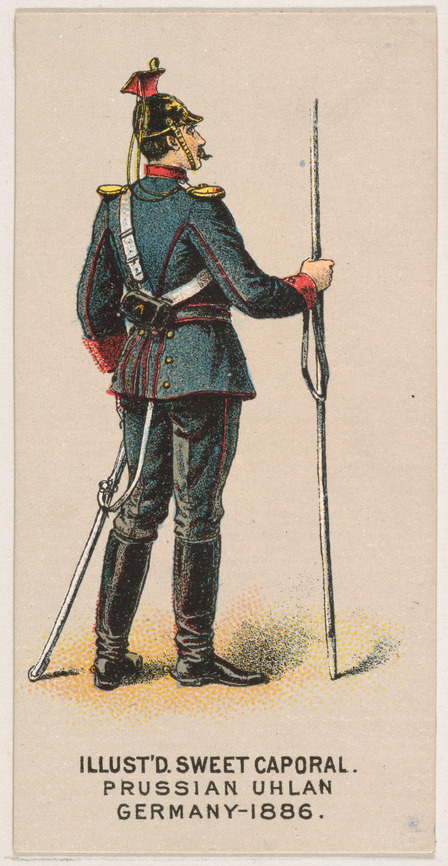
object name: print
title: Prussian Uhlan, Germany, 1886, from the Military Series (N224) issued by Kinney Tobacco Company to promote Sweet Caporal Cigarettes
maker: kinney brothers tobacco company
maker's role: publisher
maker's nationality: american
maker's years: 1869-2011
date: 1888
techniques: color lithograph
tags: military,spears,men